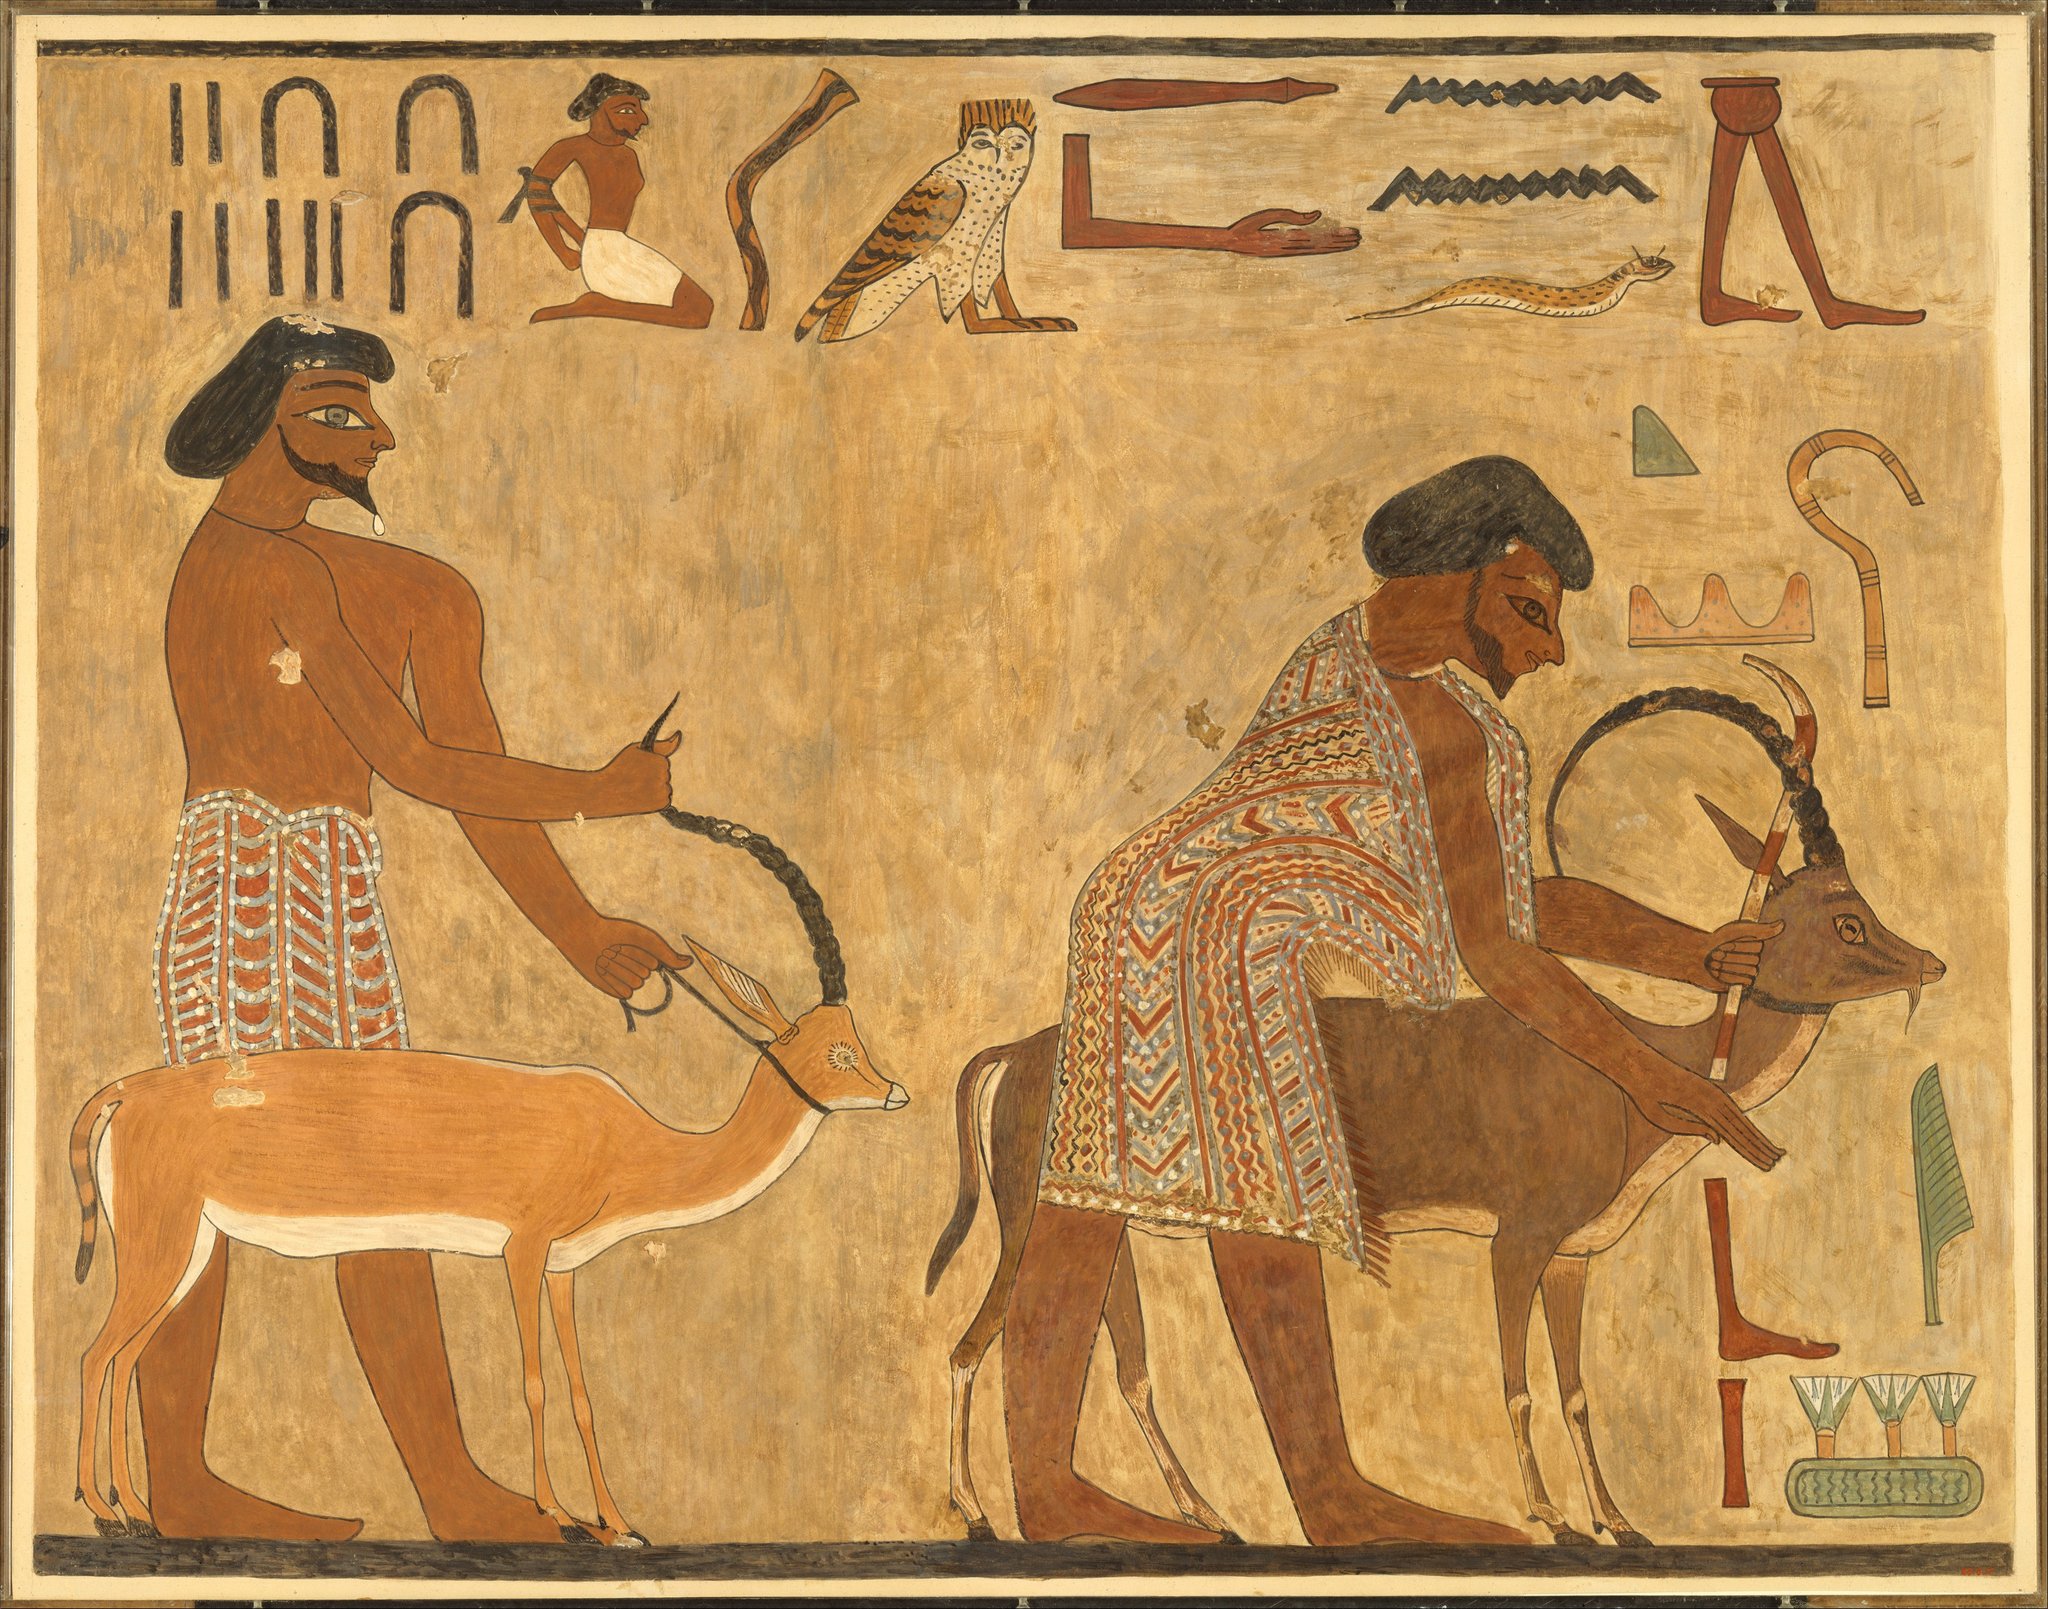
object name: facsimile, khnumhotep beni hasan 3, nomad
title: Leaders of the Aamu of Shu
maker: norman de garis davies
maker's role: artist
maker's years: 1865-1941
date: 1887-1878 BCE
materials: paper, paint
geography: egypt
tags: animals,men,walk-like-egyptian